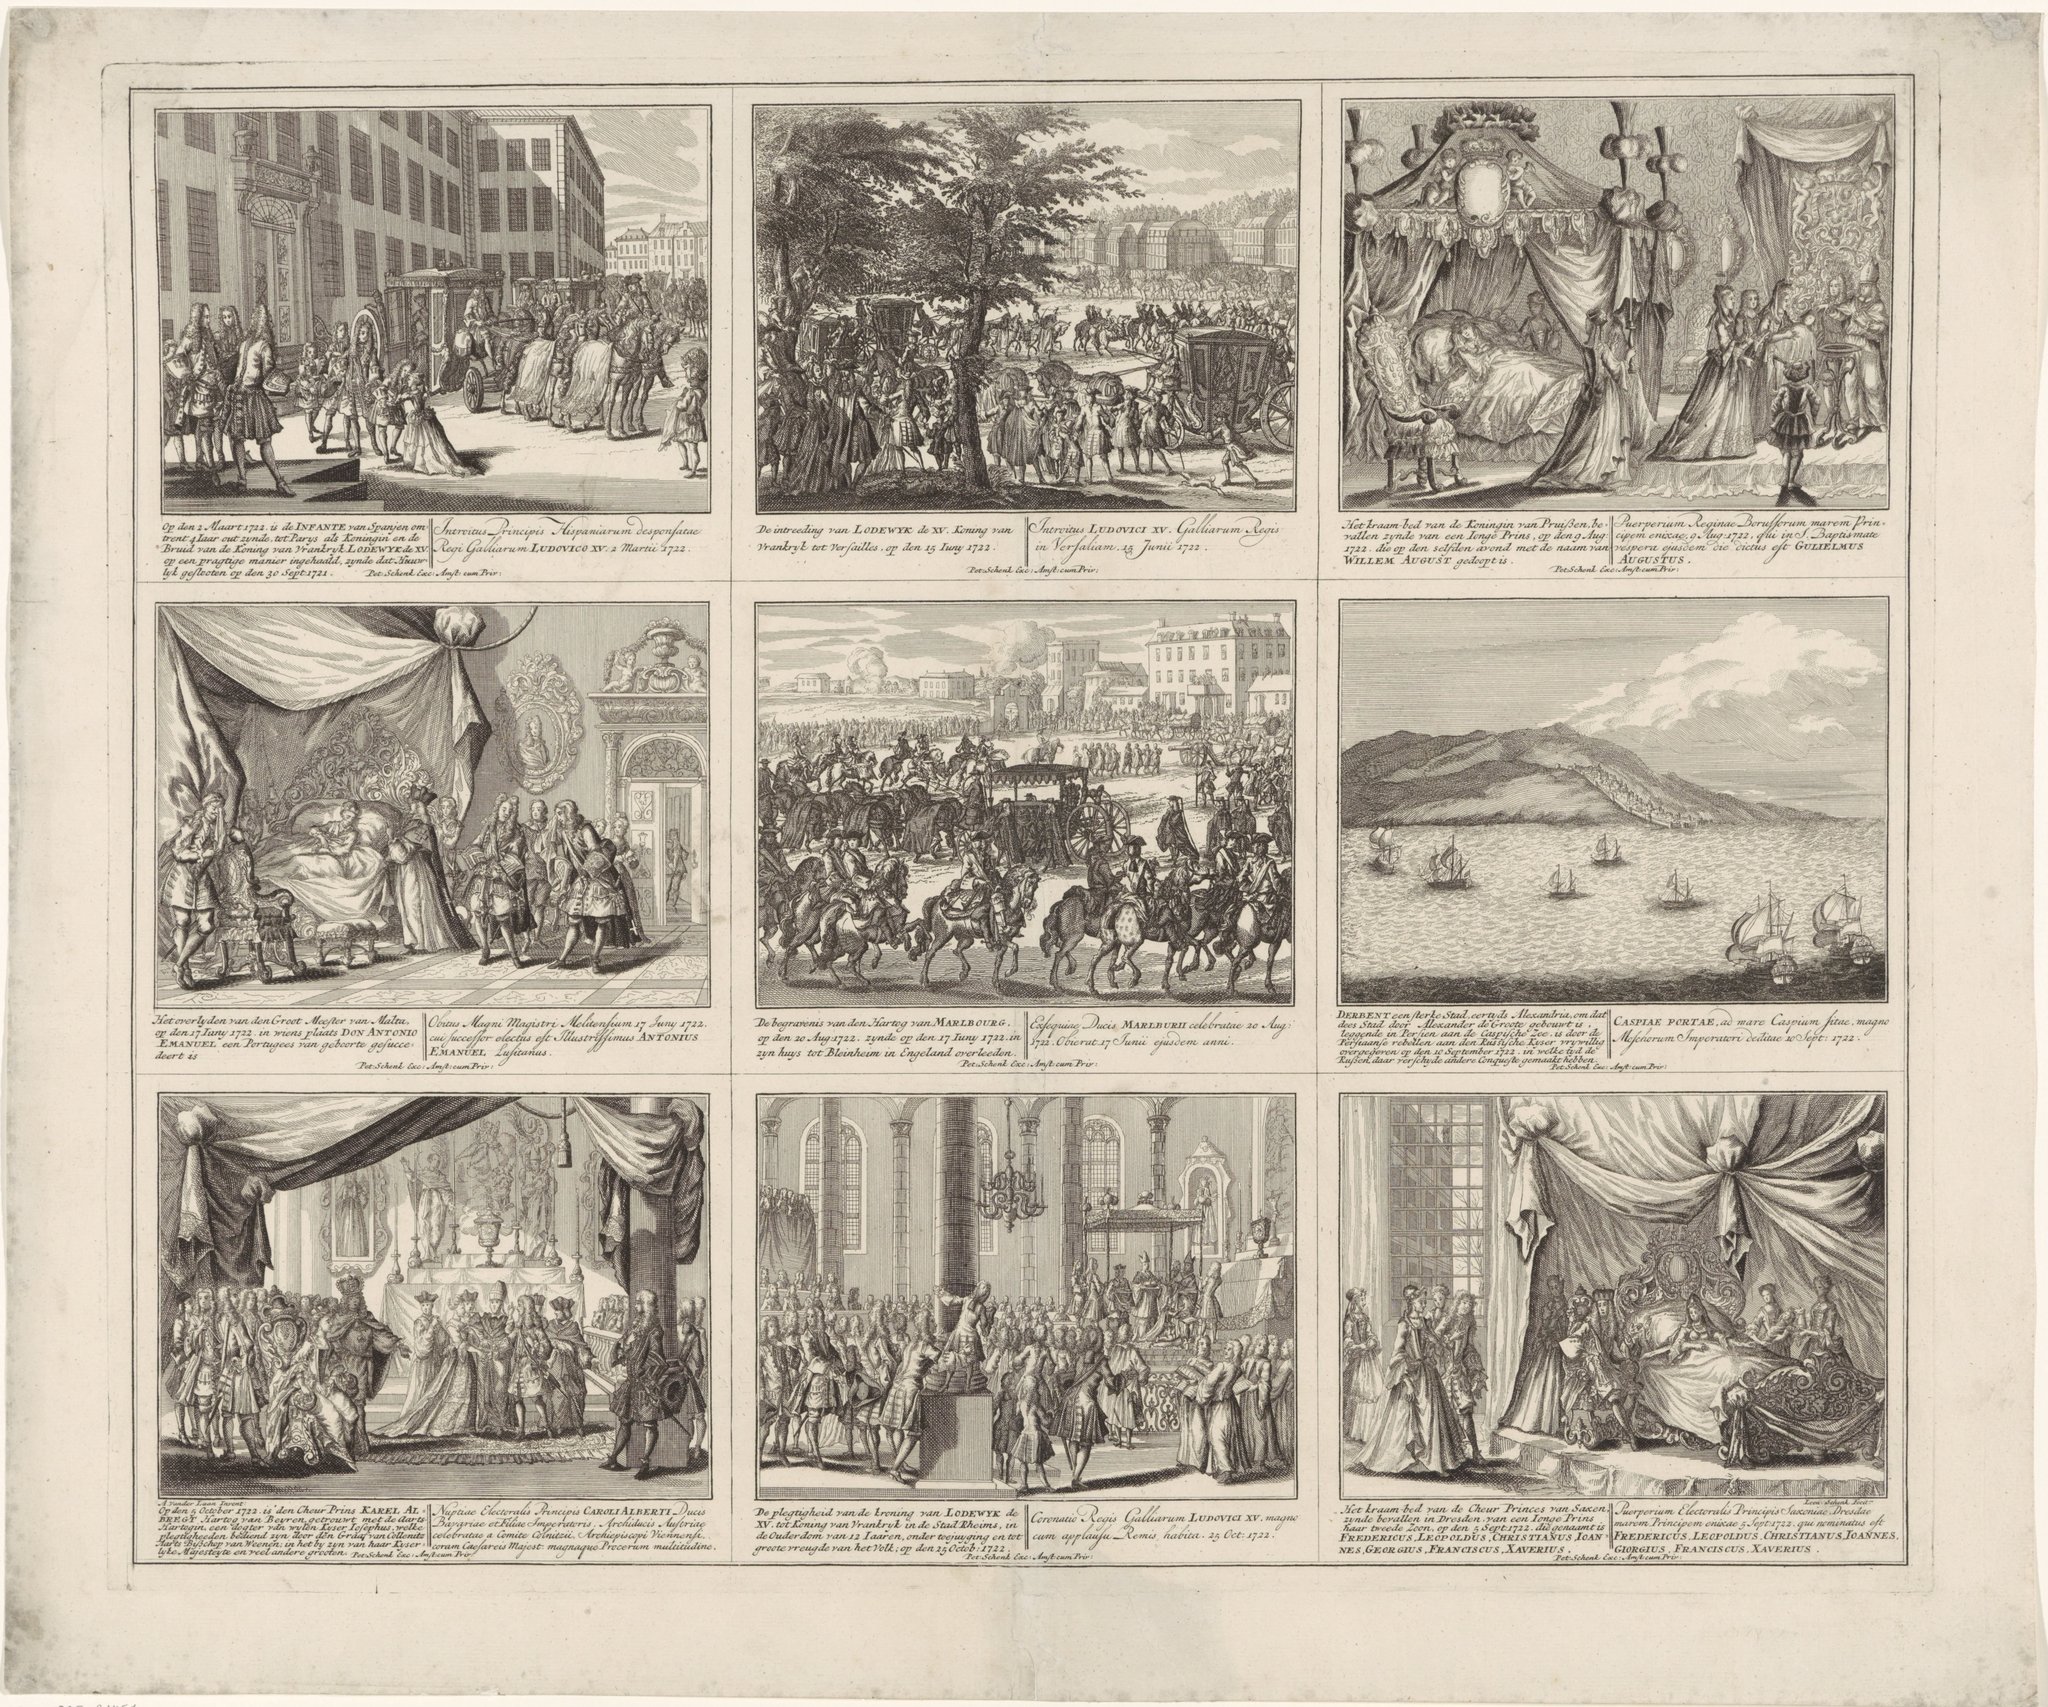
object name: print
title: Schouwburg van den oorlog (blad XXIII), 1722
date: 1721-1722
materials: paper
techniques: etching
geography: amsterdam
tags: louis xv of france, deathbed, coronation of a ruler, (civil) marriage ceremonies, confinement, birth, paris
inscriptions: collector's mark: Lugt 2228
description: Blad met negen voorstellingen van gebeurtenissen uit het jaar 1722.